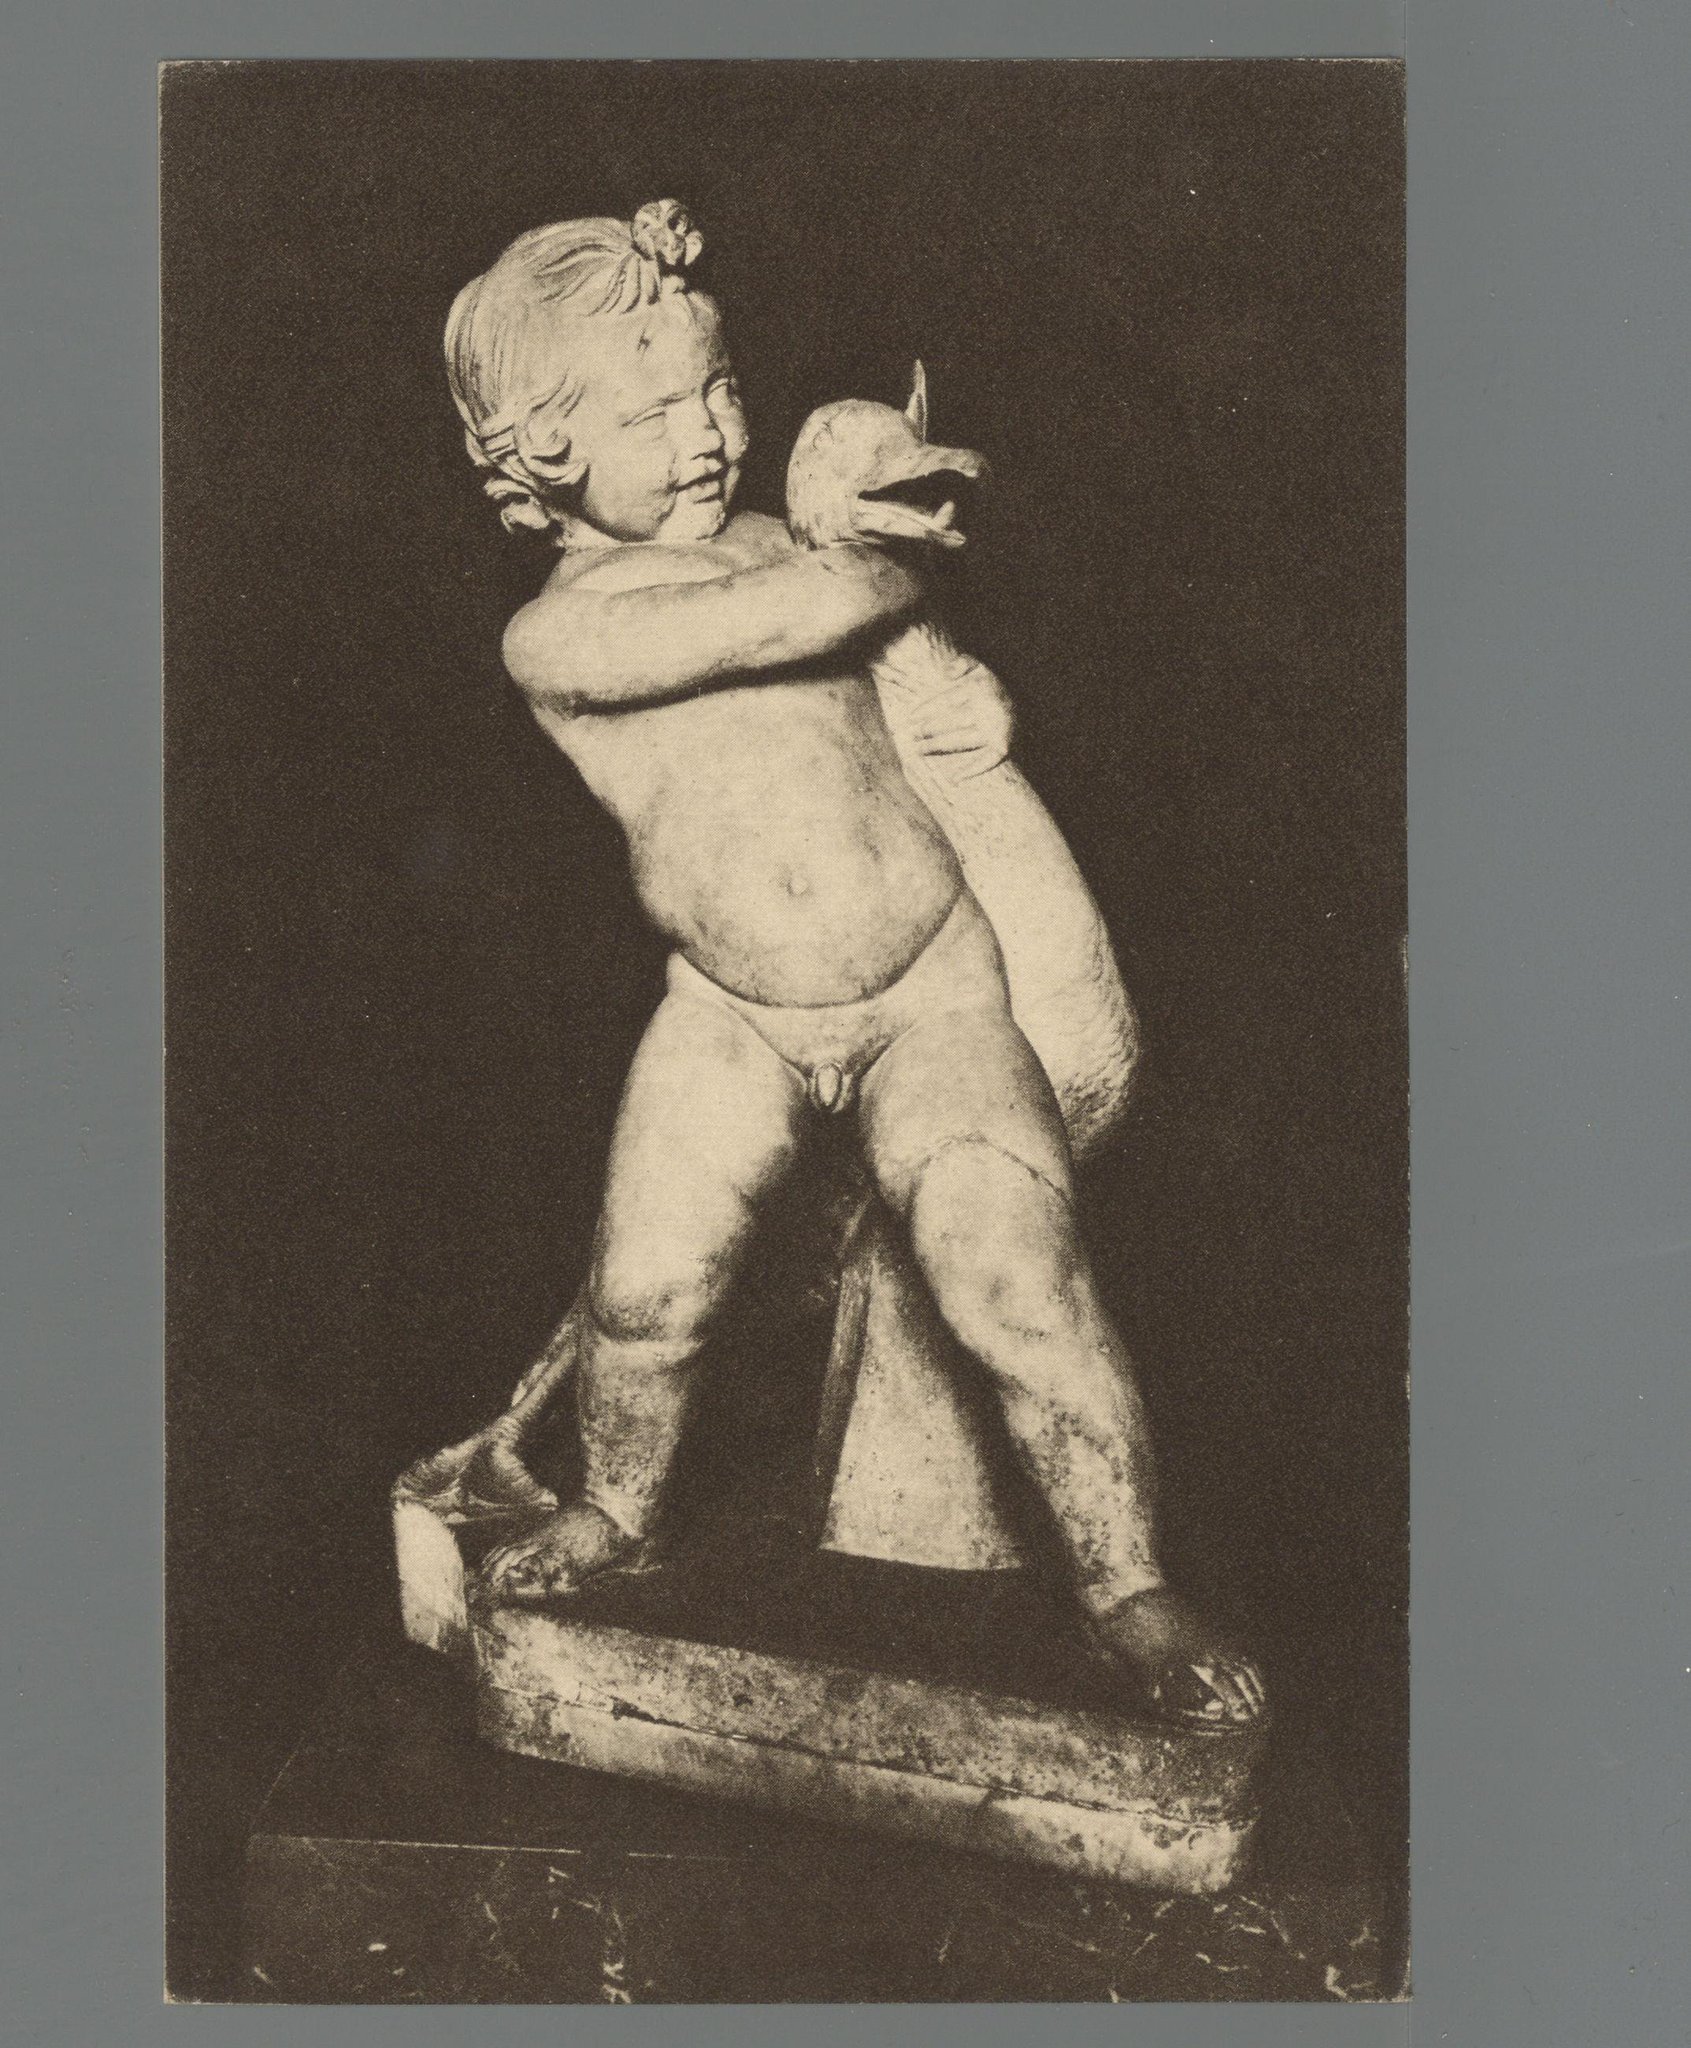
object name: photomechanical print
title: Knabe mit der Gans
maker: Anonymous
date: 1905-1930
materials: cardboard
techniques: rotogravure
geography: munich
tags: monument, statue, permanent exhibition, museum